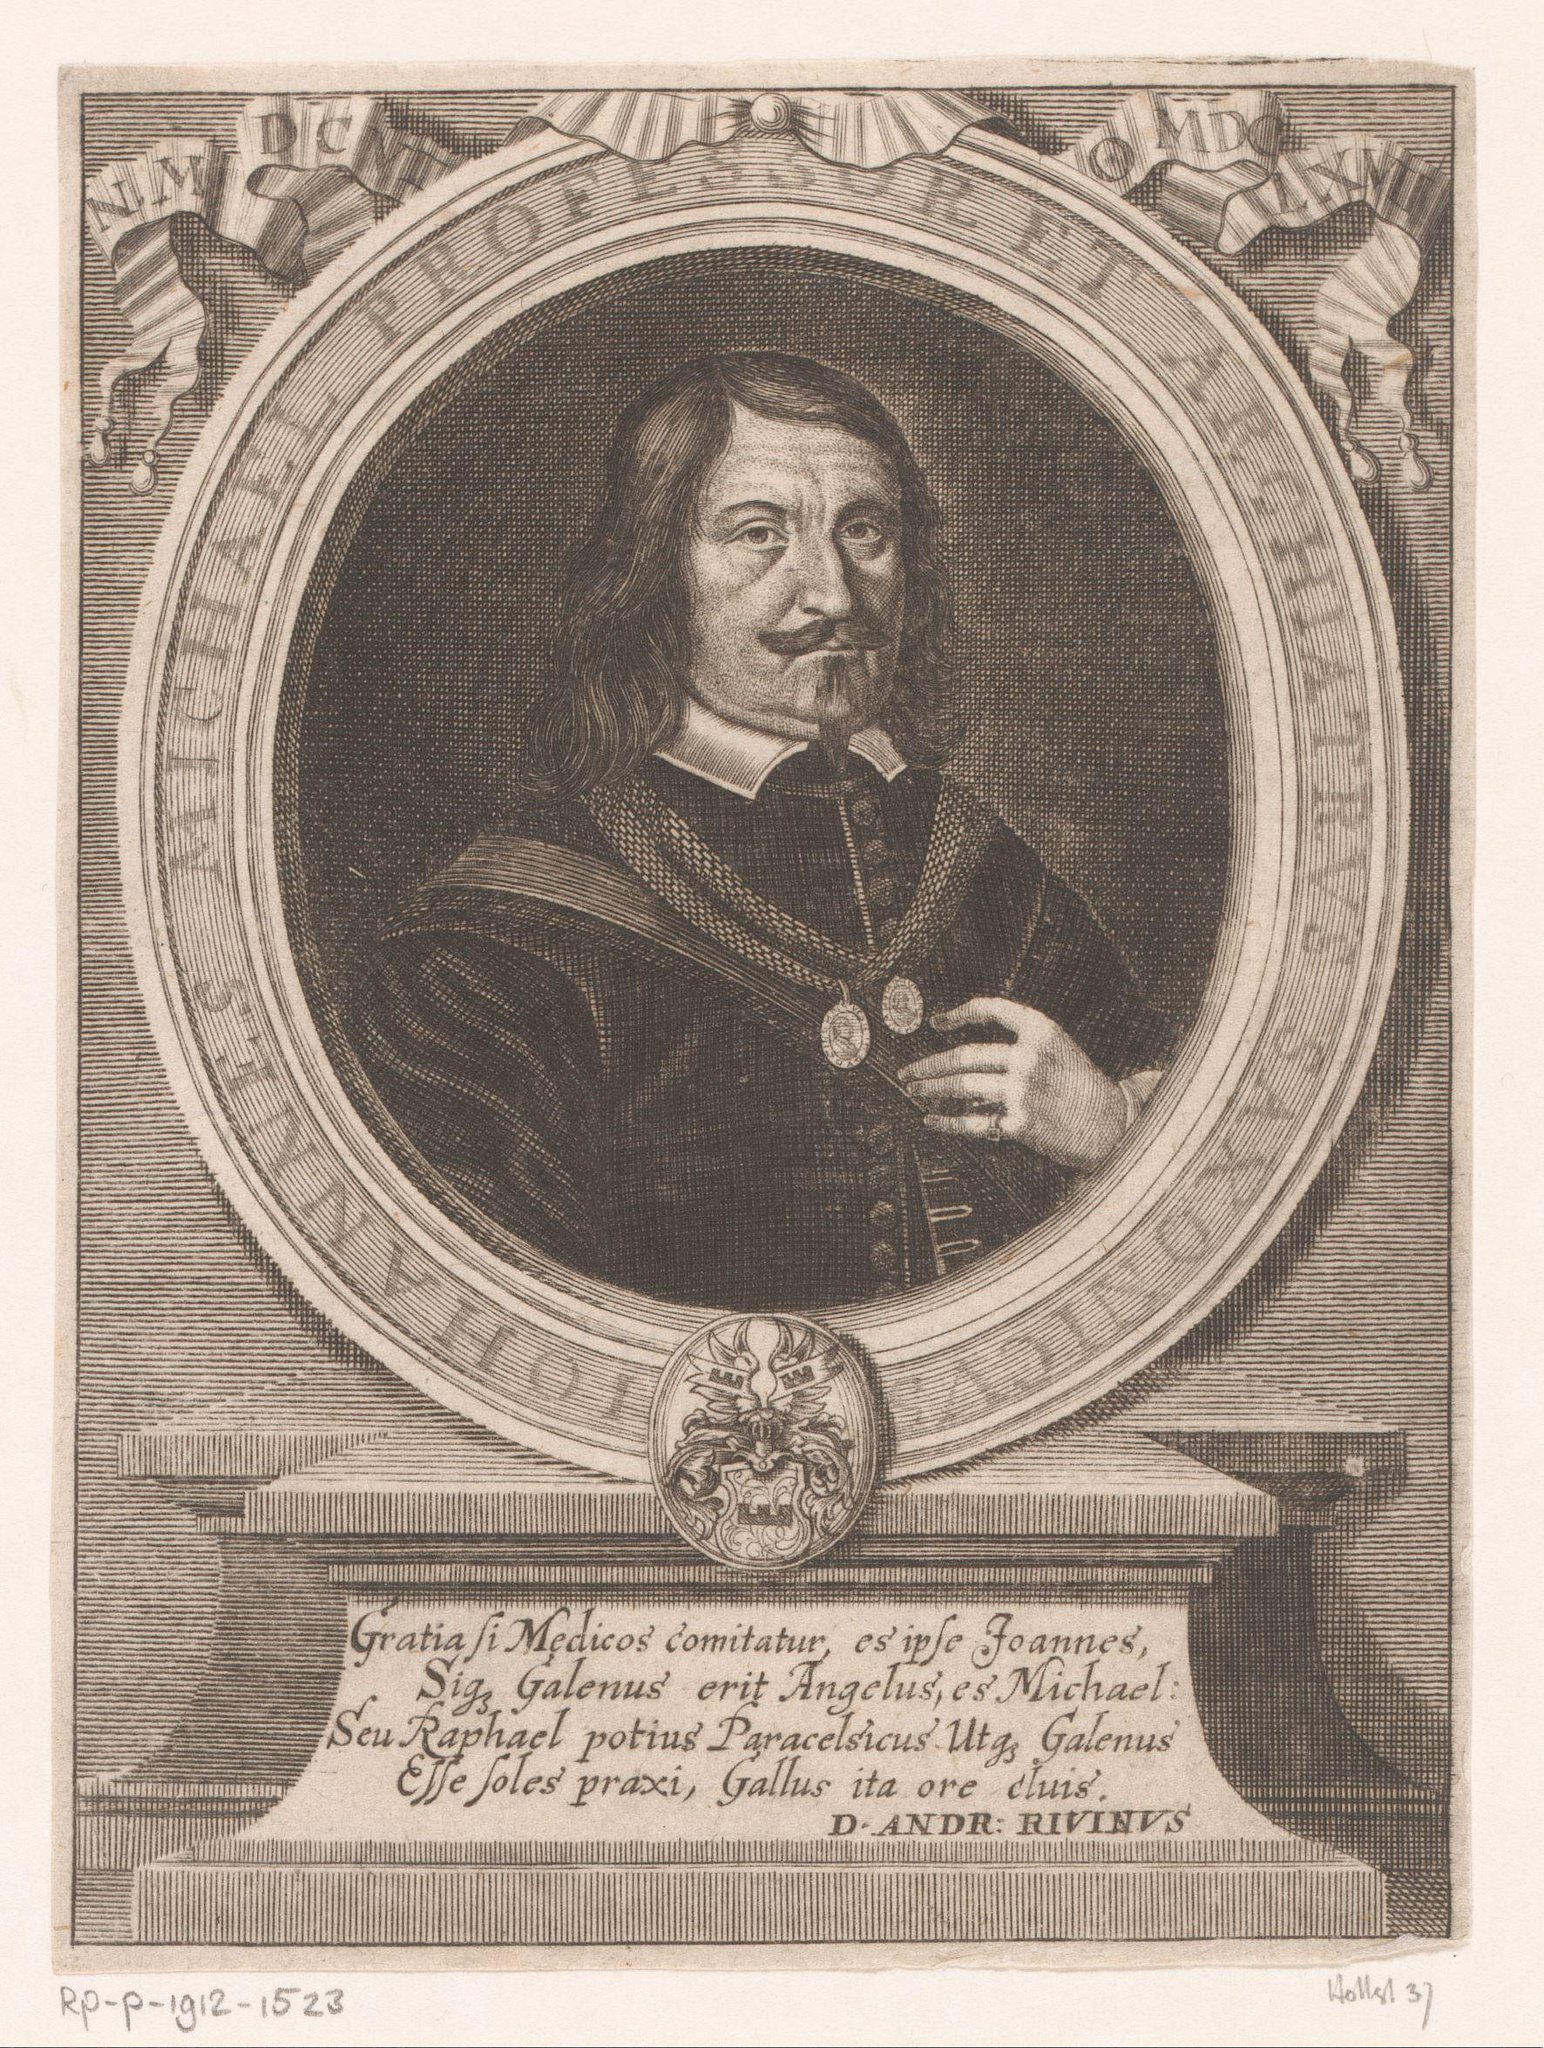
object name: print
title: Portret van Johann Michael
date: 1667-1685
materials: paper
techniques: engraving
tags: ornament ~ medallion, historical persons, pendant, trinket, 'breloque', armorial bearing, heraldry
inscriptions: collector's mark: Lugt 2228